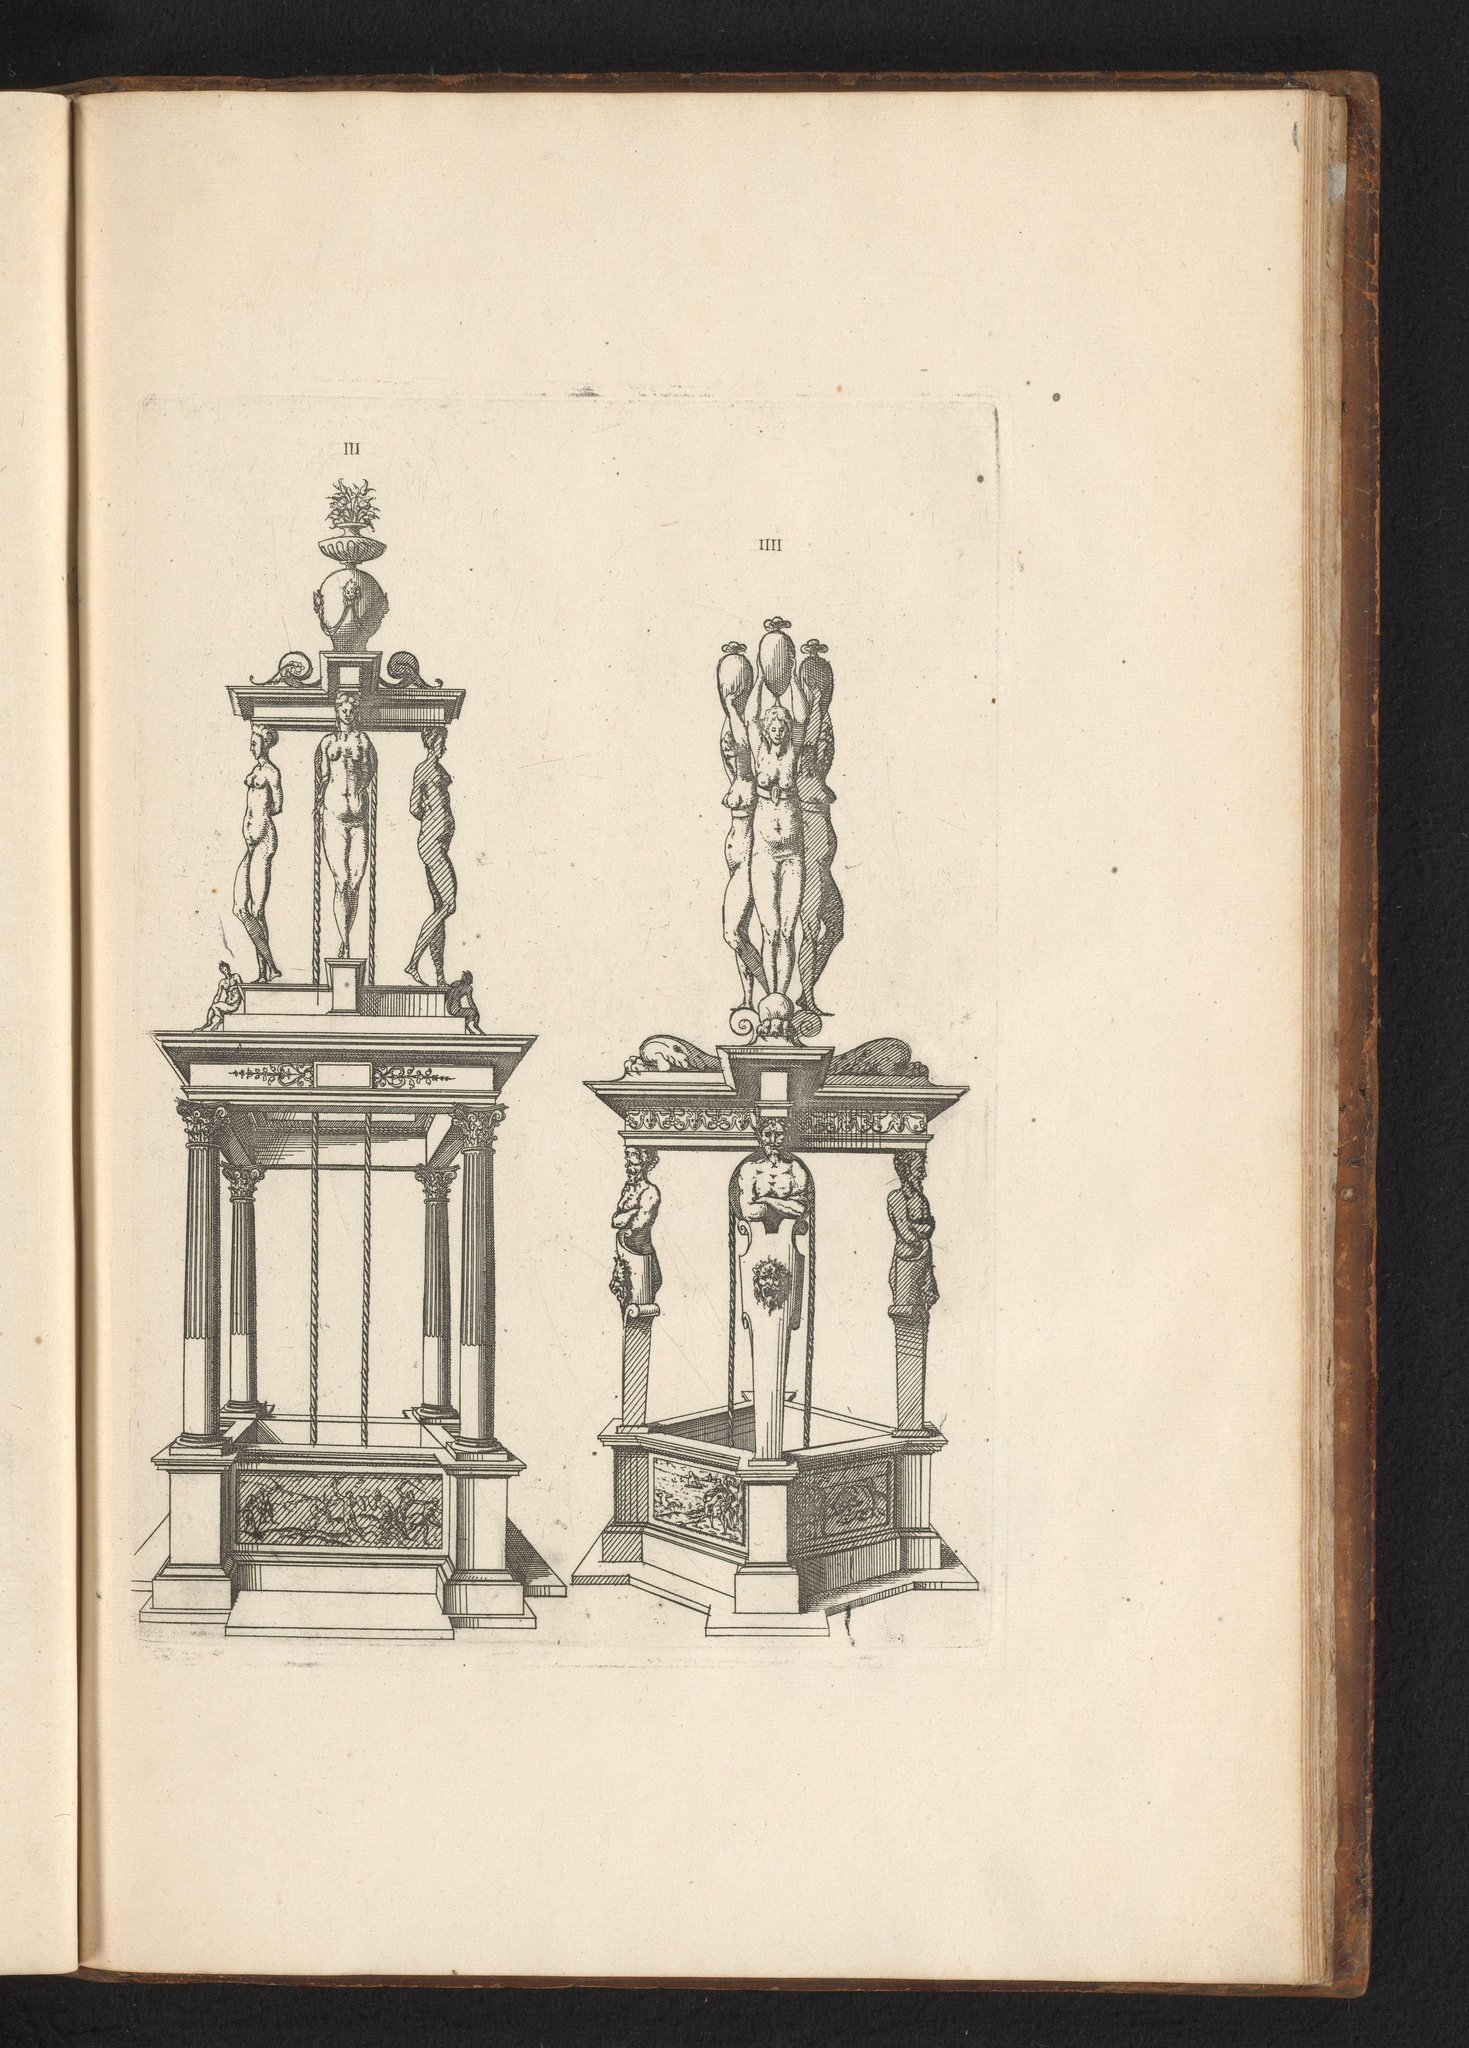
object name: ornament print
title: Twee waterputten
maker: jacques androuet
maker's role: draughtsman, print maker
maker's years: 1515-1584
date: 1561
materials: paper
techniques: etching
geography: paris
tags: well, atlantes ~ architecture, caryatids ~ architecture, architectural design or model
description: Twee waterputten, met kariatiden en atlanten. Onderdeel van 'Seconde livre d'architectvre' (1561): 64 etsen met geornamenteerde architectuuronderdelen.